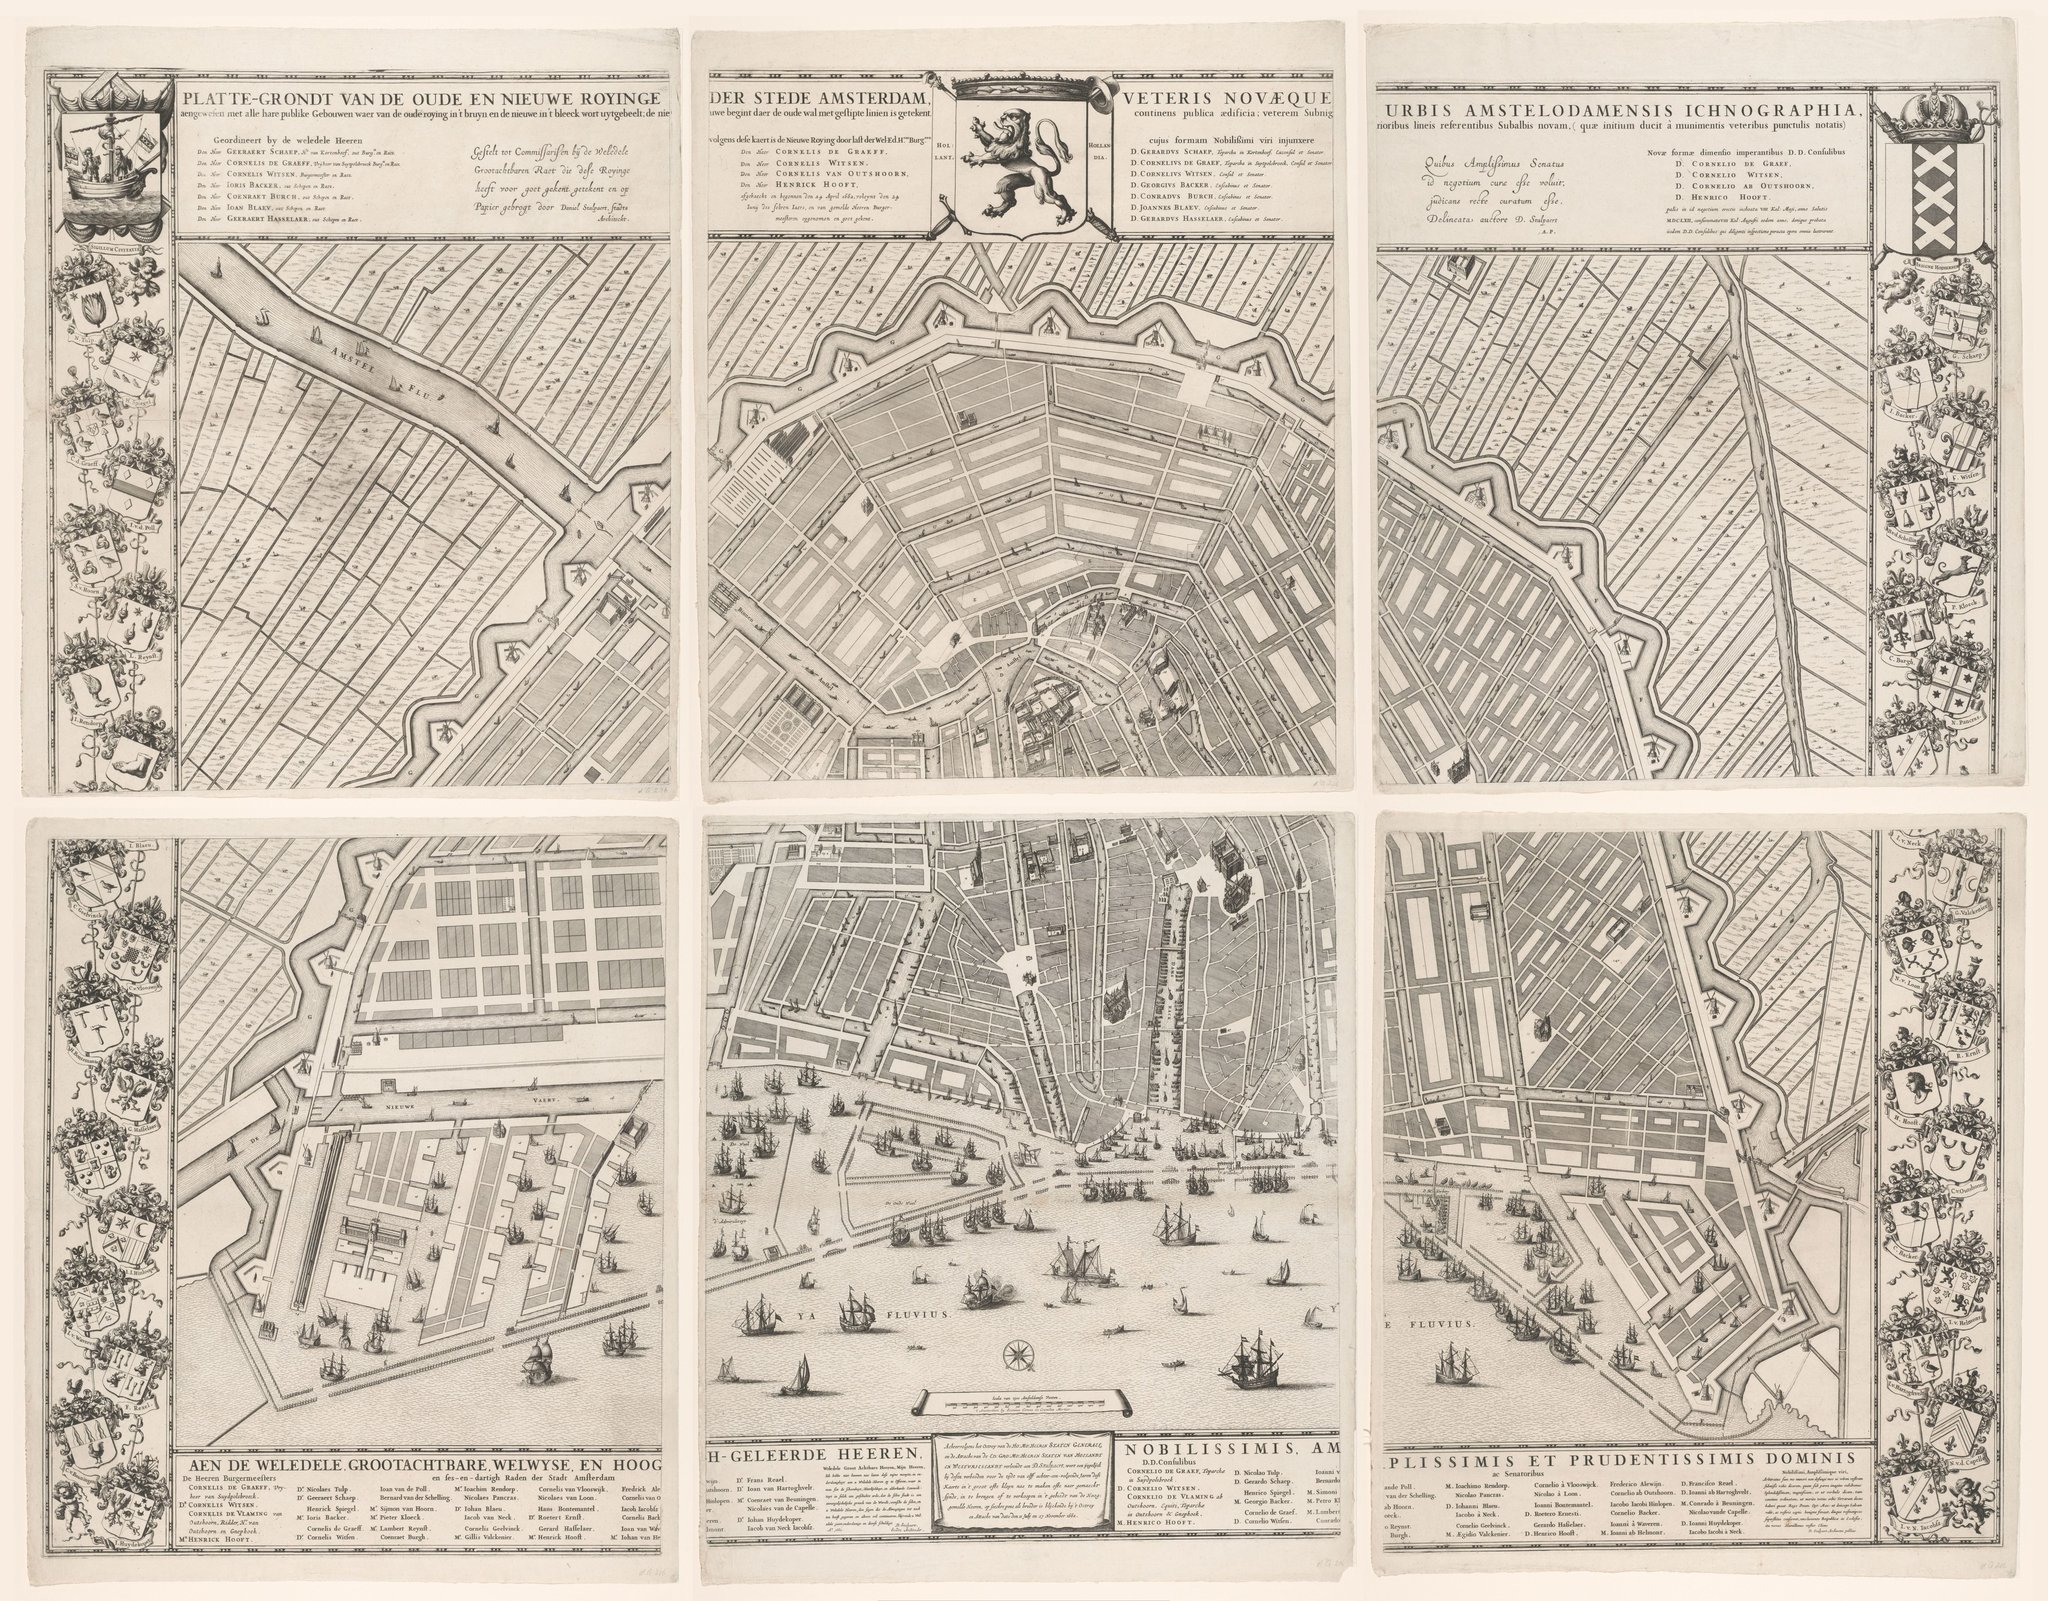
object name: print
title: Plattegrond van Amsterdam met ontwerp en uitvoering van de Vierde Uitleg, bestaande uit zes delen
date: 1601-1663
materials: paper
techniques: engraving, etching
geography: amsterdam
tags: coat of arms (as symbol of the state, etc.) (+ city; municipal), seal (as symbol of the state, etc.) (+ city; municipal), maps of cities, coat of arms (as symbol of the state, etc.) (+ province; provincial), armorial bearing, heraldry, amsterdam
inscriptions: collector's mark: Lugt 195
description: Plattegrond van Amsterdam met het ontwerp van Daniel Stalpaert voor de Vierde Uitleg (uitbreiding). Het destijds nieuw te bouwen deel is lichter gearceerd en, gezien deze staat is uitgegeven nadat de uitleg werd uitgevoerd, aangepast aan de latere situatie. Zo zijn later gebouwde gebouwen toegevoegd en heeft de Plantage een nieuwe perceelsgewijze invulling gekregen. Boven in het midden het wapen van Holland. Links daarvan, in het Nederlands, de titel met daaronder de namen van de zeven leden van de commissie die tot taak had de vroedschap te adviseren over de Vierde Uitleg (links) en de namen van de vier burgemeesters uit het jaar 1662, die opdracht tot uitvoering van de uitleg gaven (rechts). Rechts van het genoemde wapen hetzelfde in het Latijn. Langs de linkerzijkant het stadszegel met daaronder de wapens van achttien leden van de vroedschap. Langs de rechterzijkant het wapen van de stad met daaronder de wapens van de andere achttien leden van de vroedschap. Onder in het midden een cartouche met de schaalstok: Scala van 1500 Amsteldamse Voeten. Daaronder de oude privilegevermelding in het Nederlands. Rechts daarvan, in het Nederlands, de opdracht aan de vier burgemeesters uit 1662 en de zesendertig zittende raden (vroedschapsleden) ten tijde van de presentatie van de kaart in januari 1663. Links van de privilegevermelding hetzelfde in het Latijn. Oriëntatie: zuidzuidwest boven.